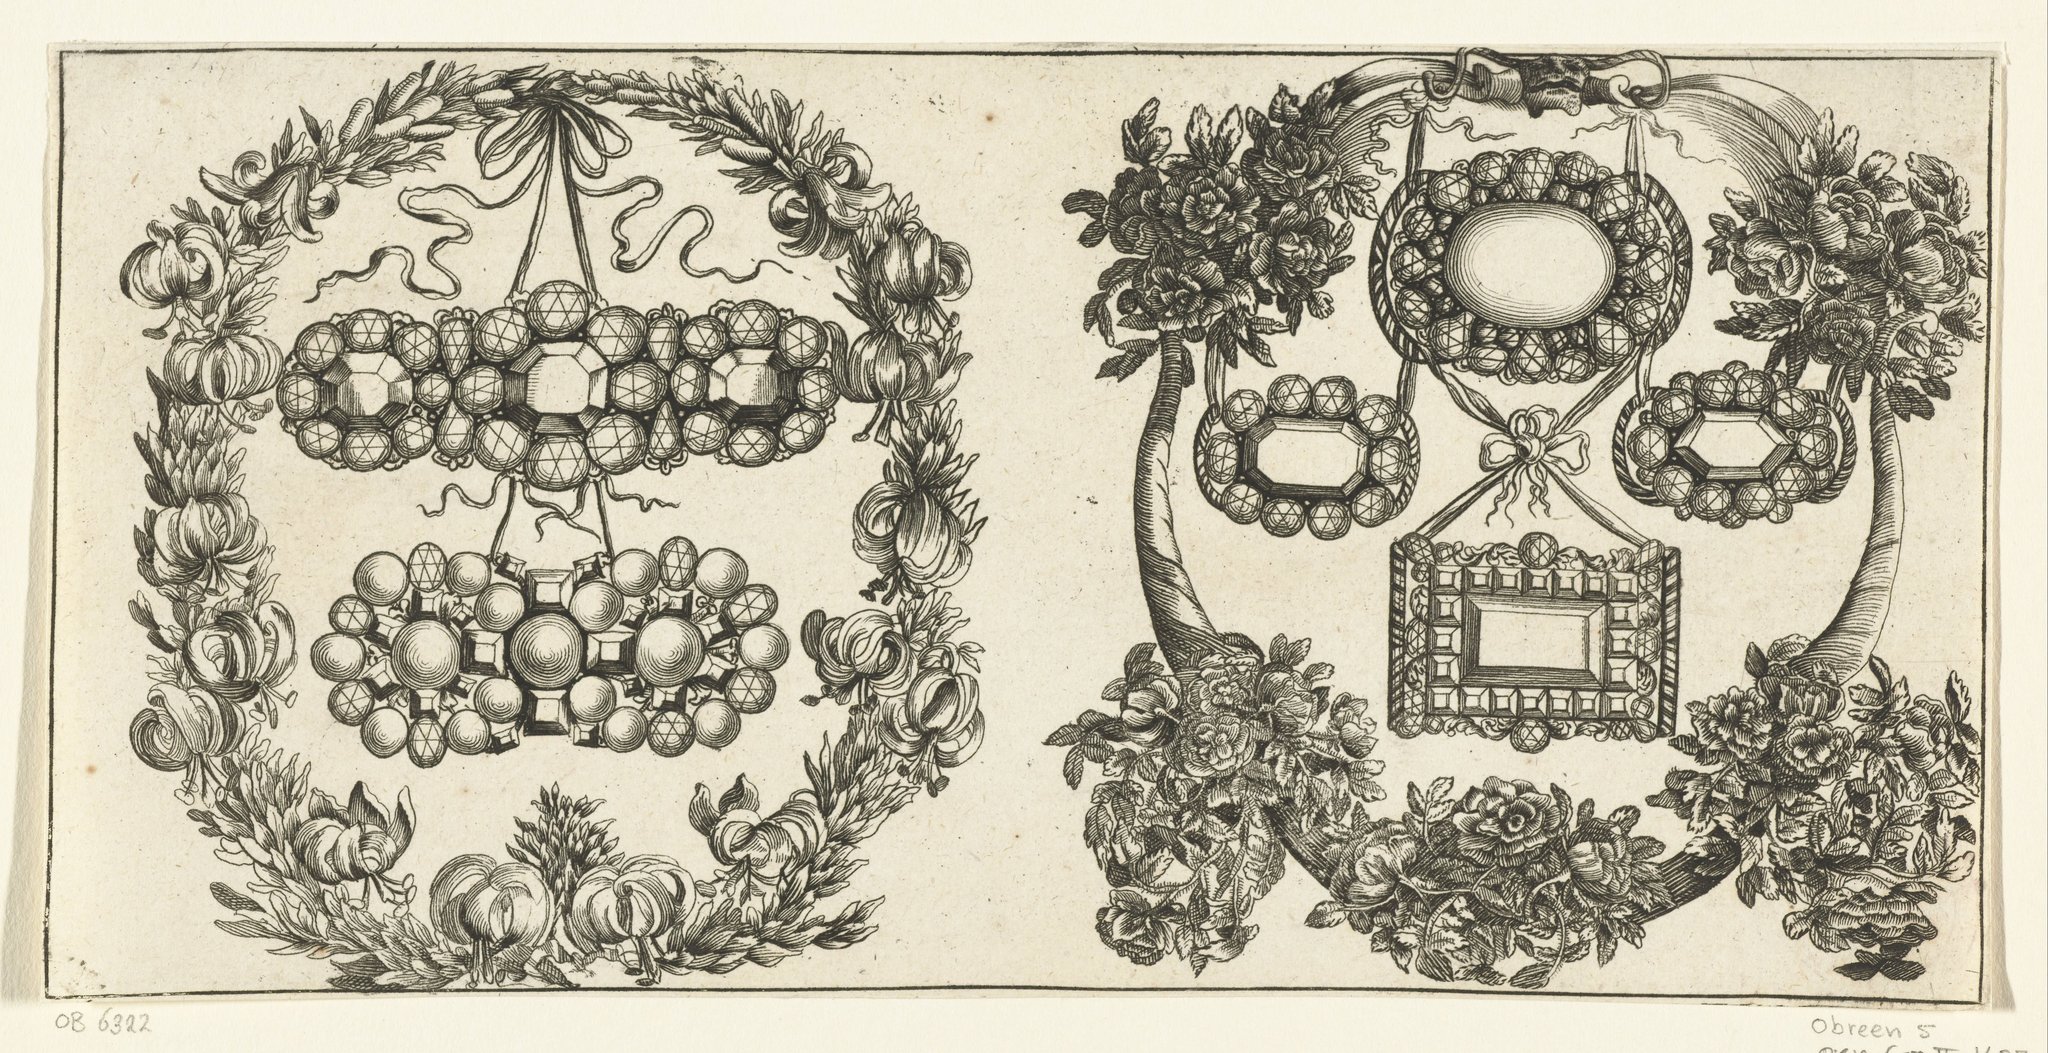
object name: print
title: Nieuw Goutsmits Boeck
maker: daniel de lafeuille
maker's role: print maker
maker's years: 1640-1709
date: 1650-1709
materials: paper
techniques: engraving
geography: amsterdam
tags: hare-hunting, rabbit-hunting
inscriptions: collector's mark: Lugt 240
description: Tegenzijdige kopieën naar ontwerpen van François Lefebvre: links naar RP-P-1961-89, rechts naar RP-P-1961-91. Uit serie bestaande uit een titelblad en 4 bladen, elk met ontwerpen voor juwelen in een ornamentele rand van festons, bladeren, bloemen en hoorns des overvloeds.